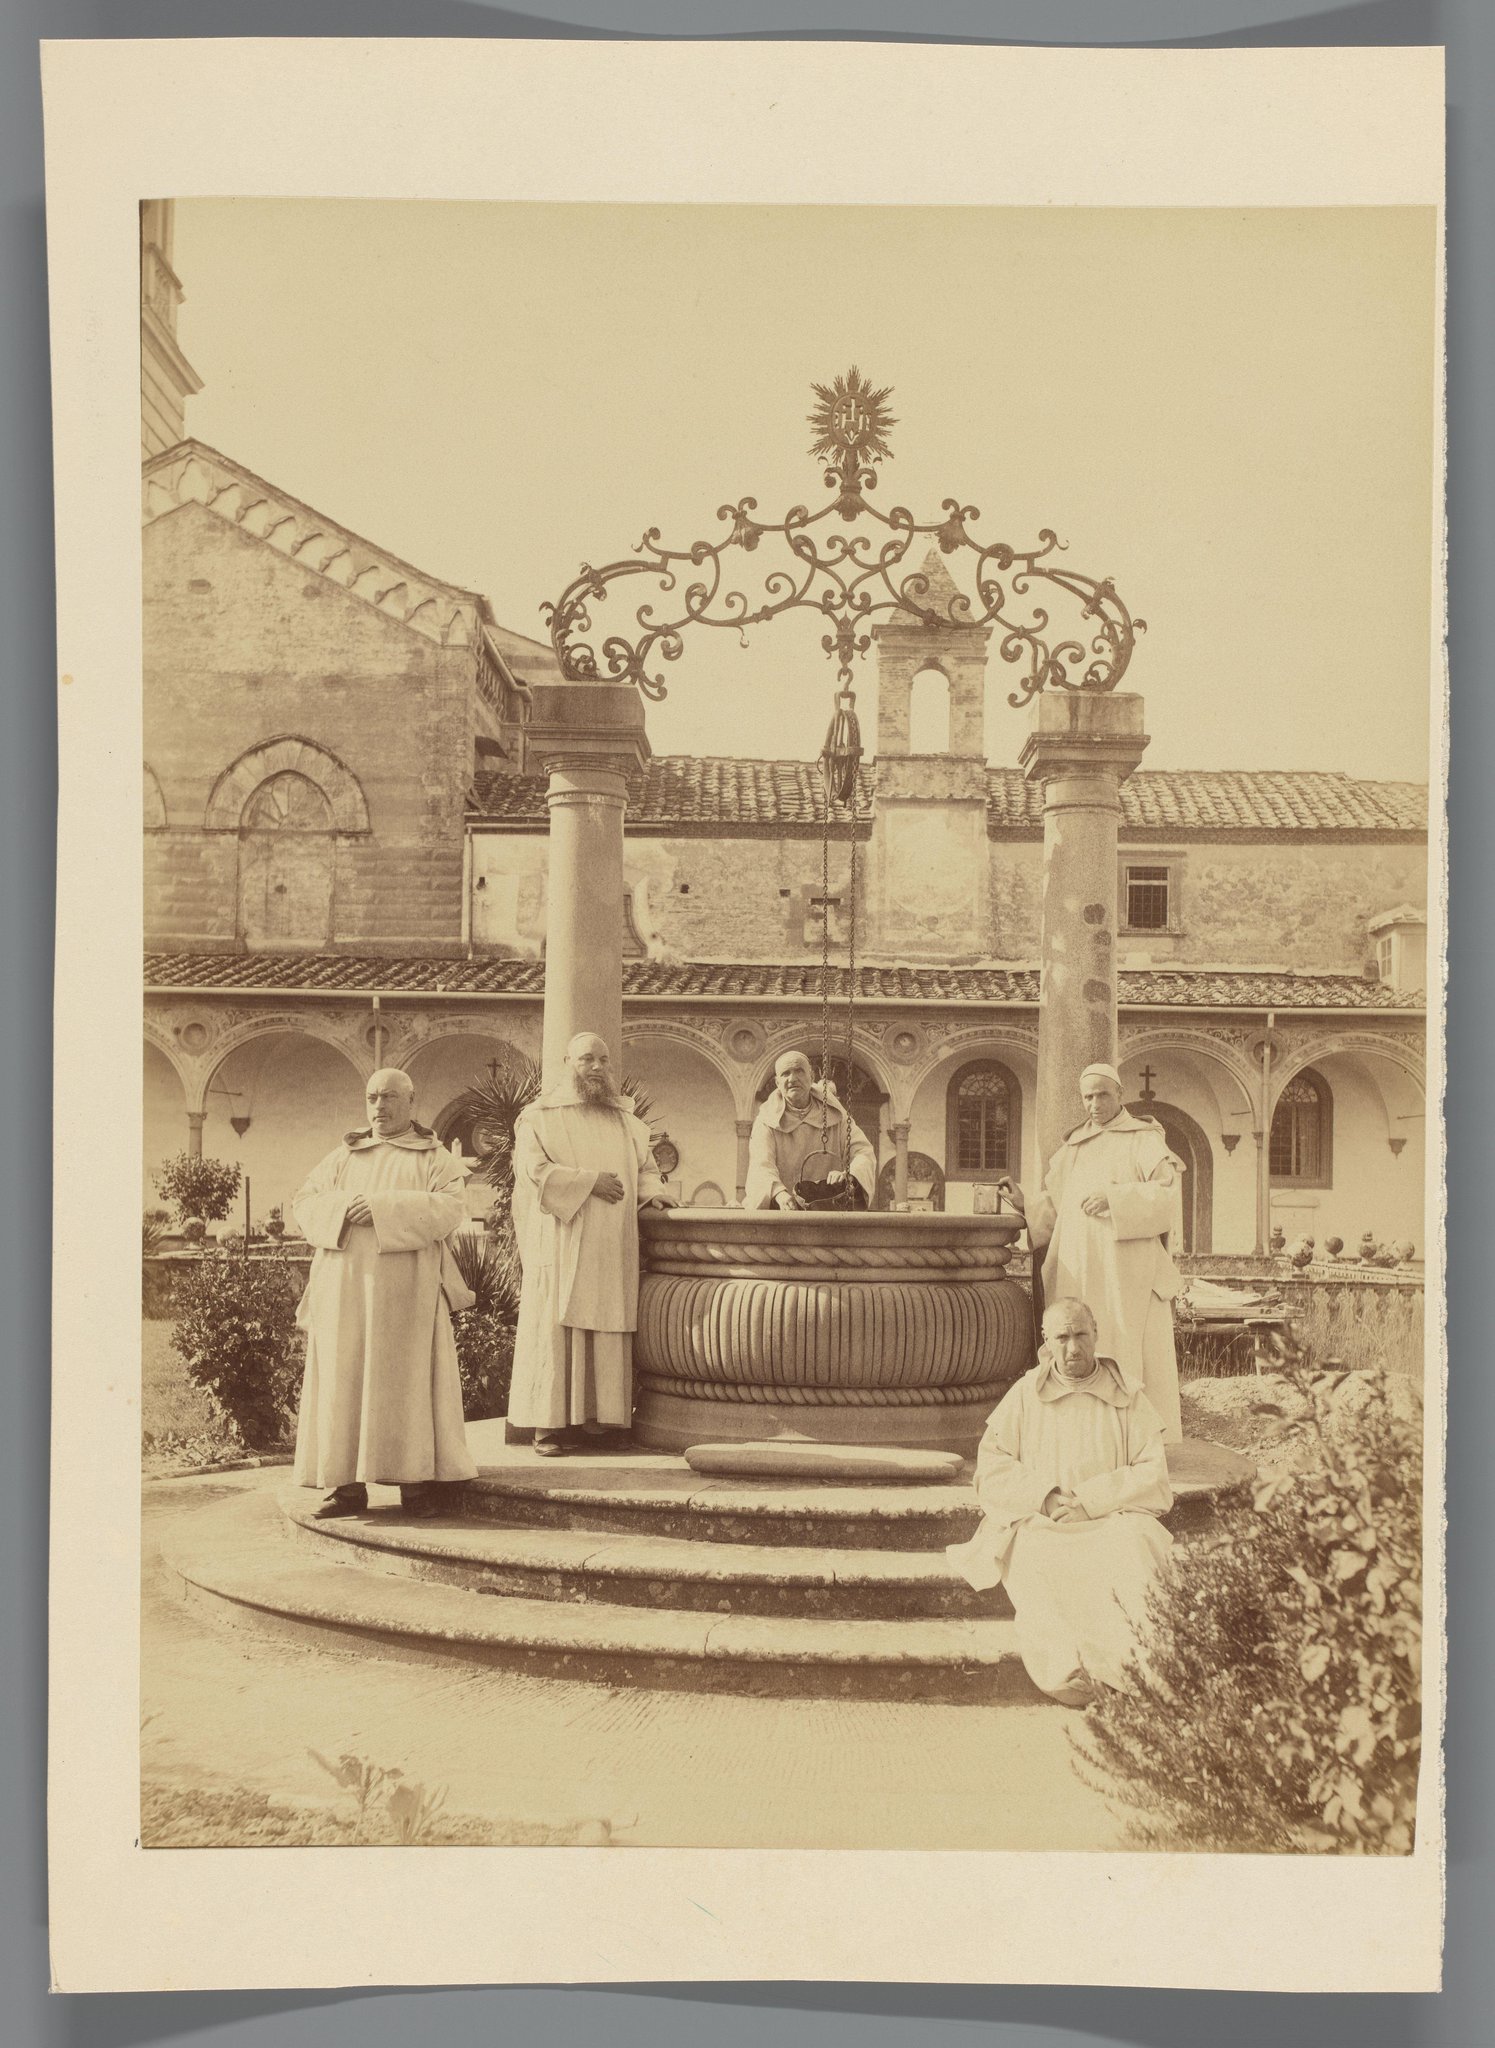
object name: photograph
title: Italië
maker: Anonymous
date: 1880-1910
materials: photographic support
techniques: albumen print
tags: italy